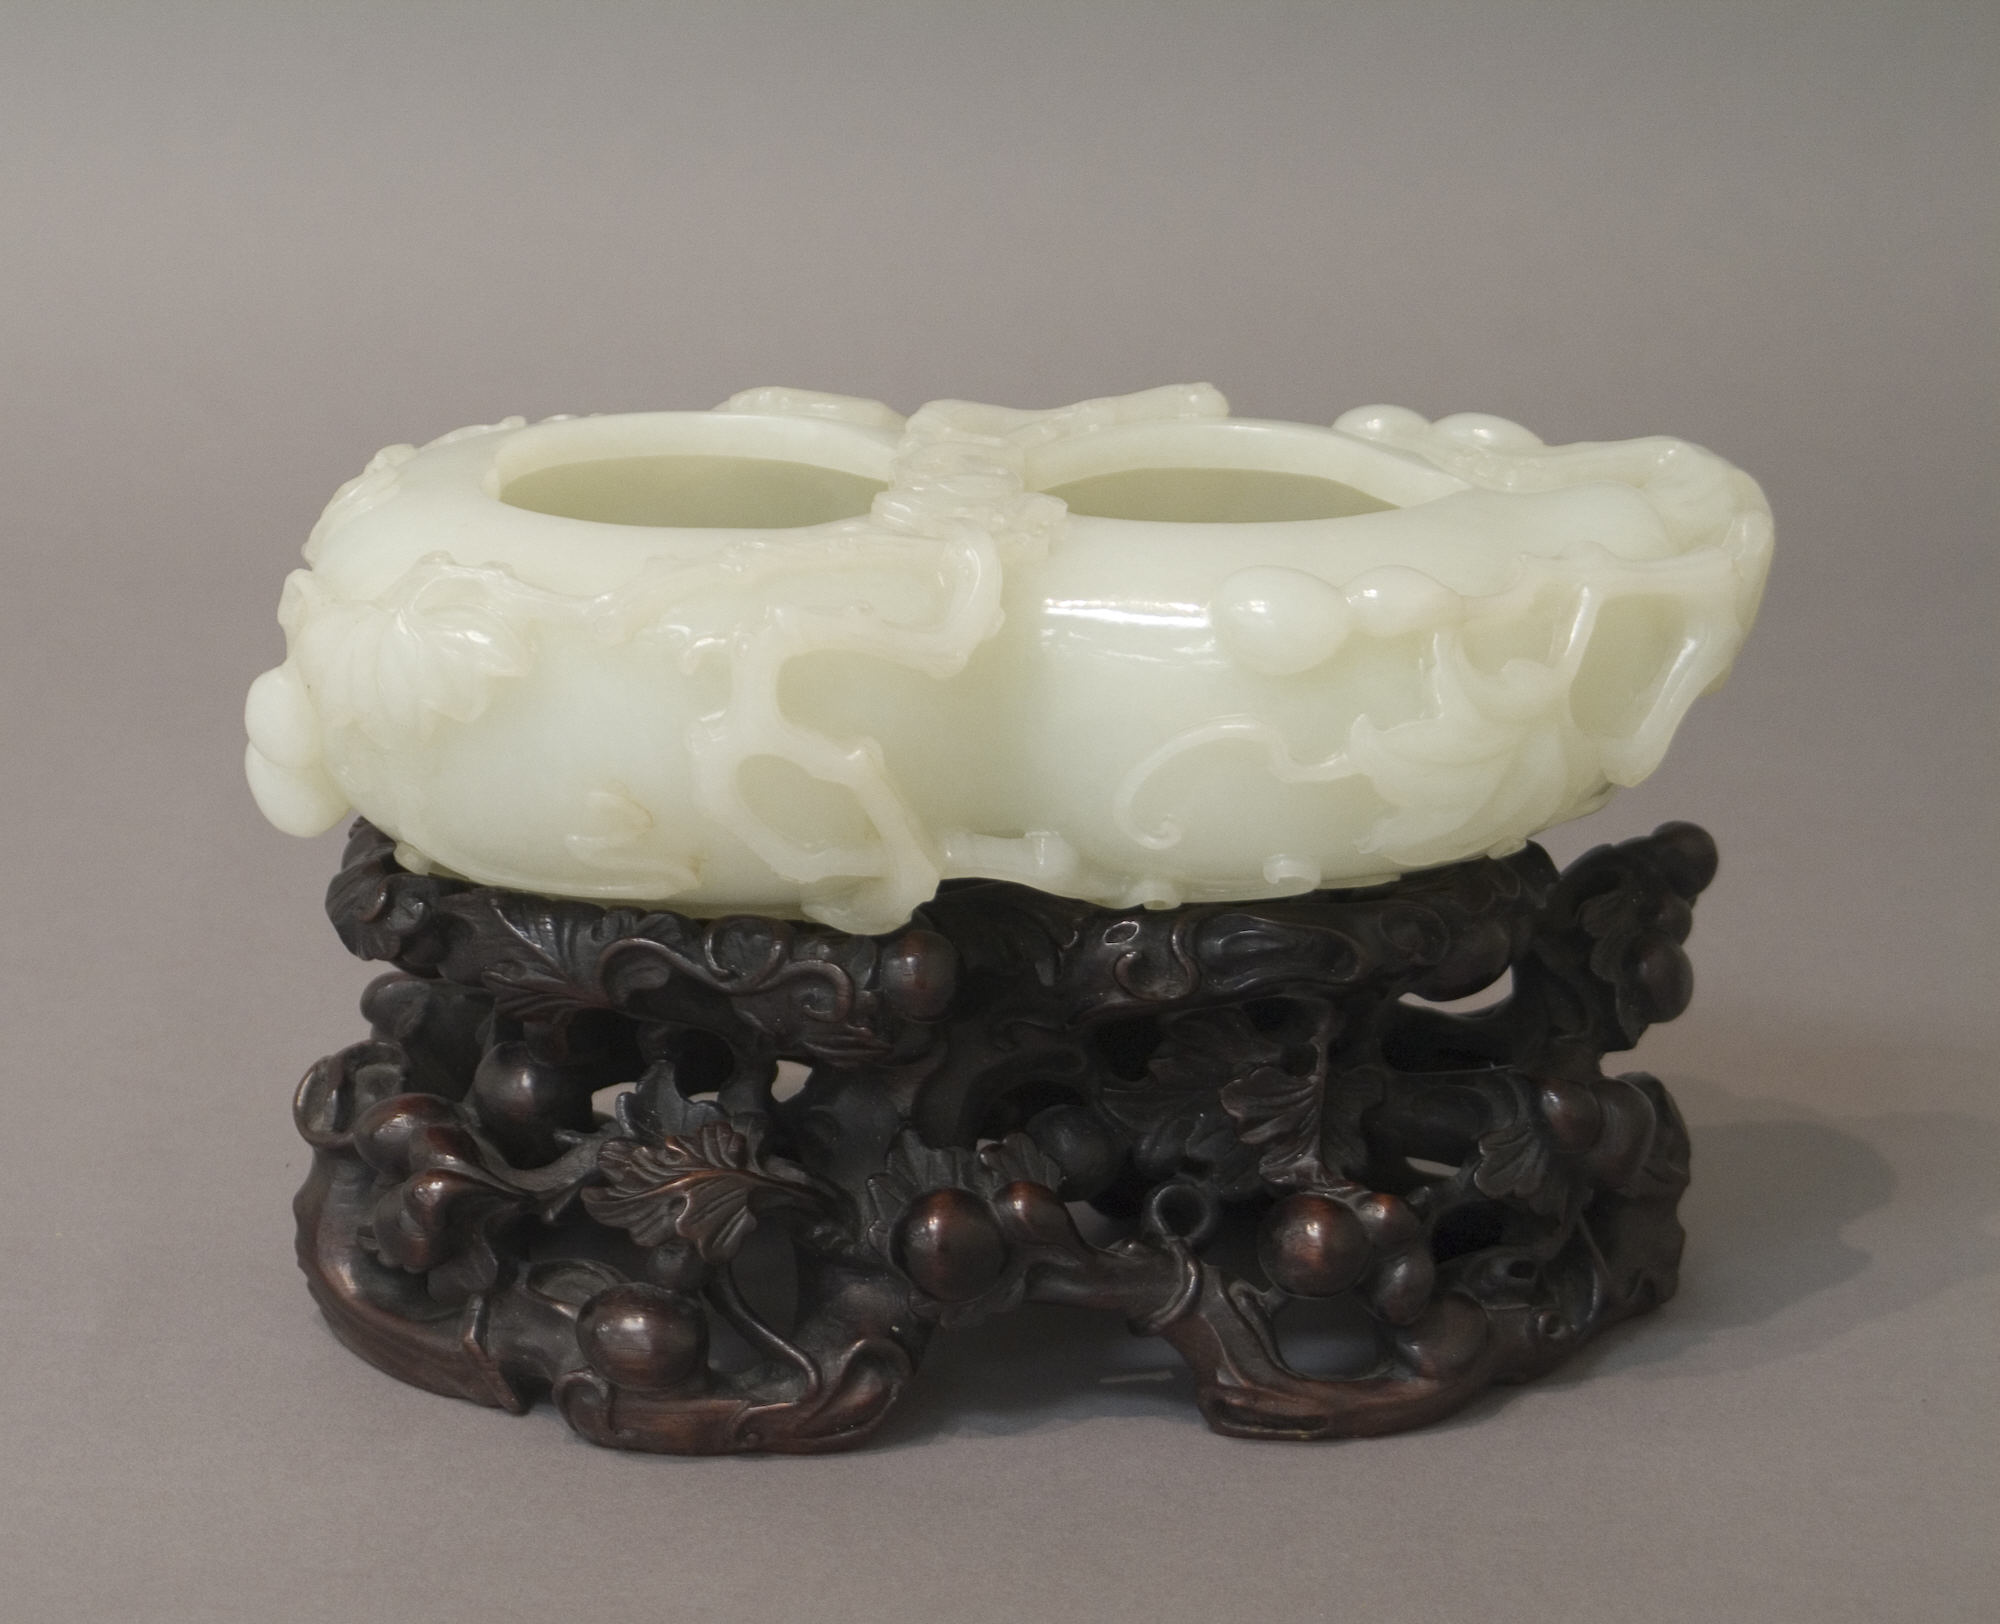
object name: water receptacle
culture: chinese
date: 1736-1795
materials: jade